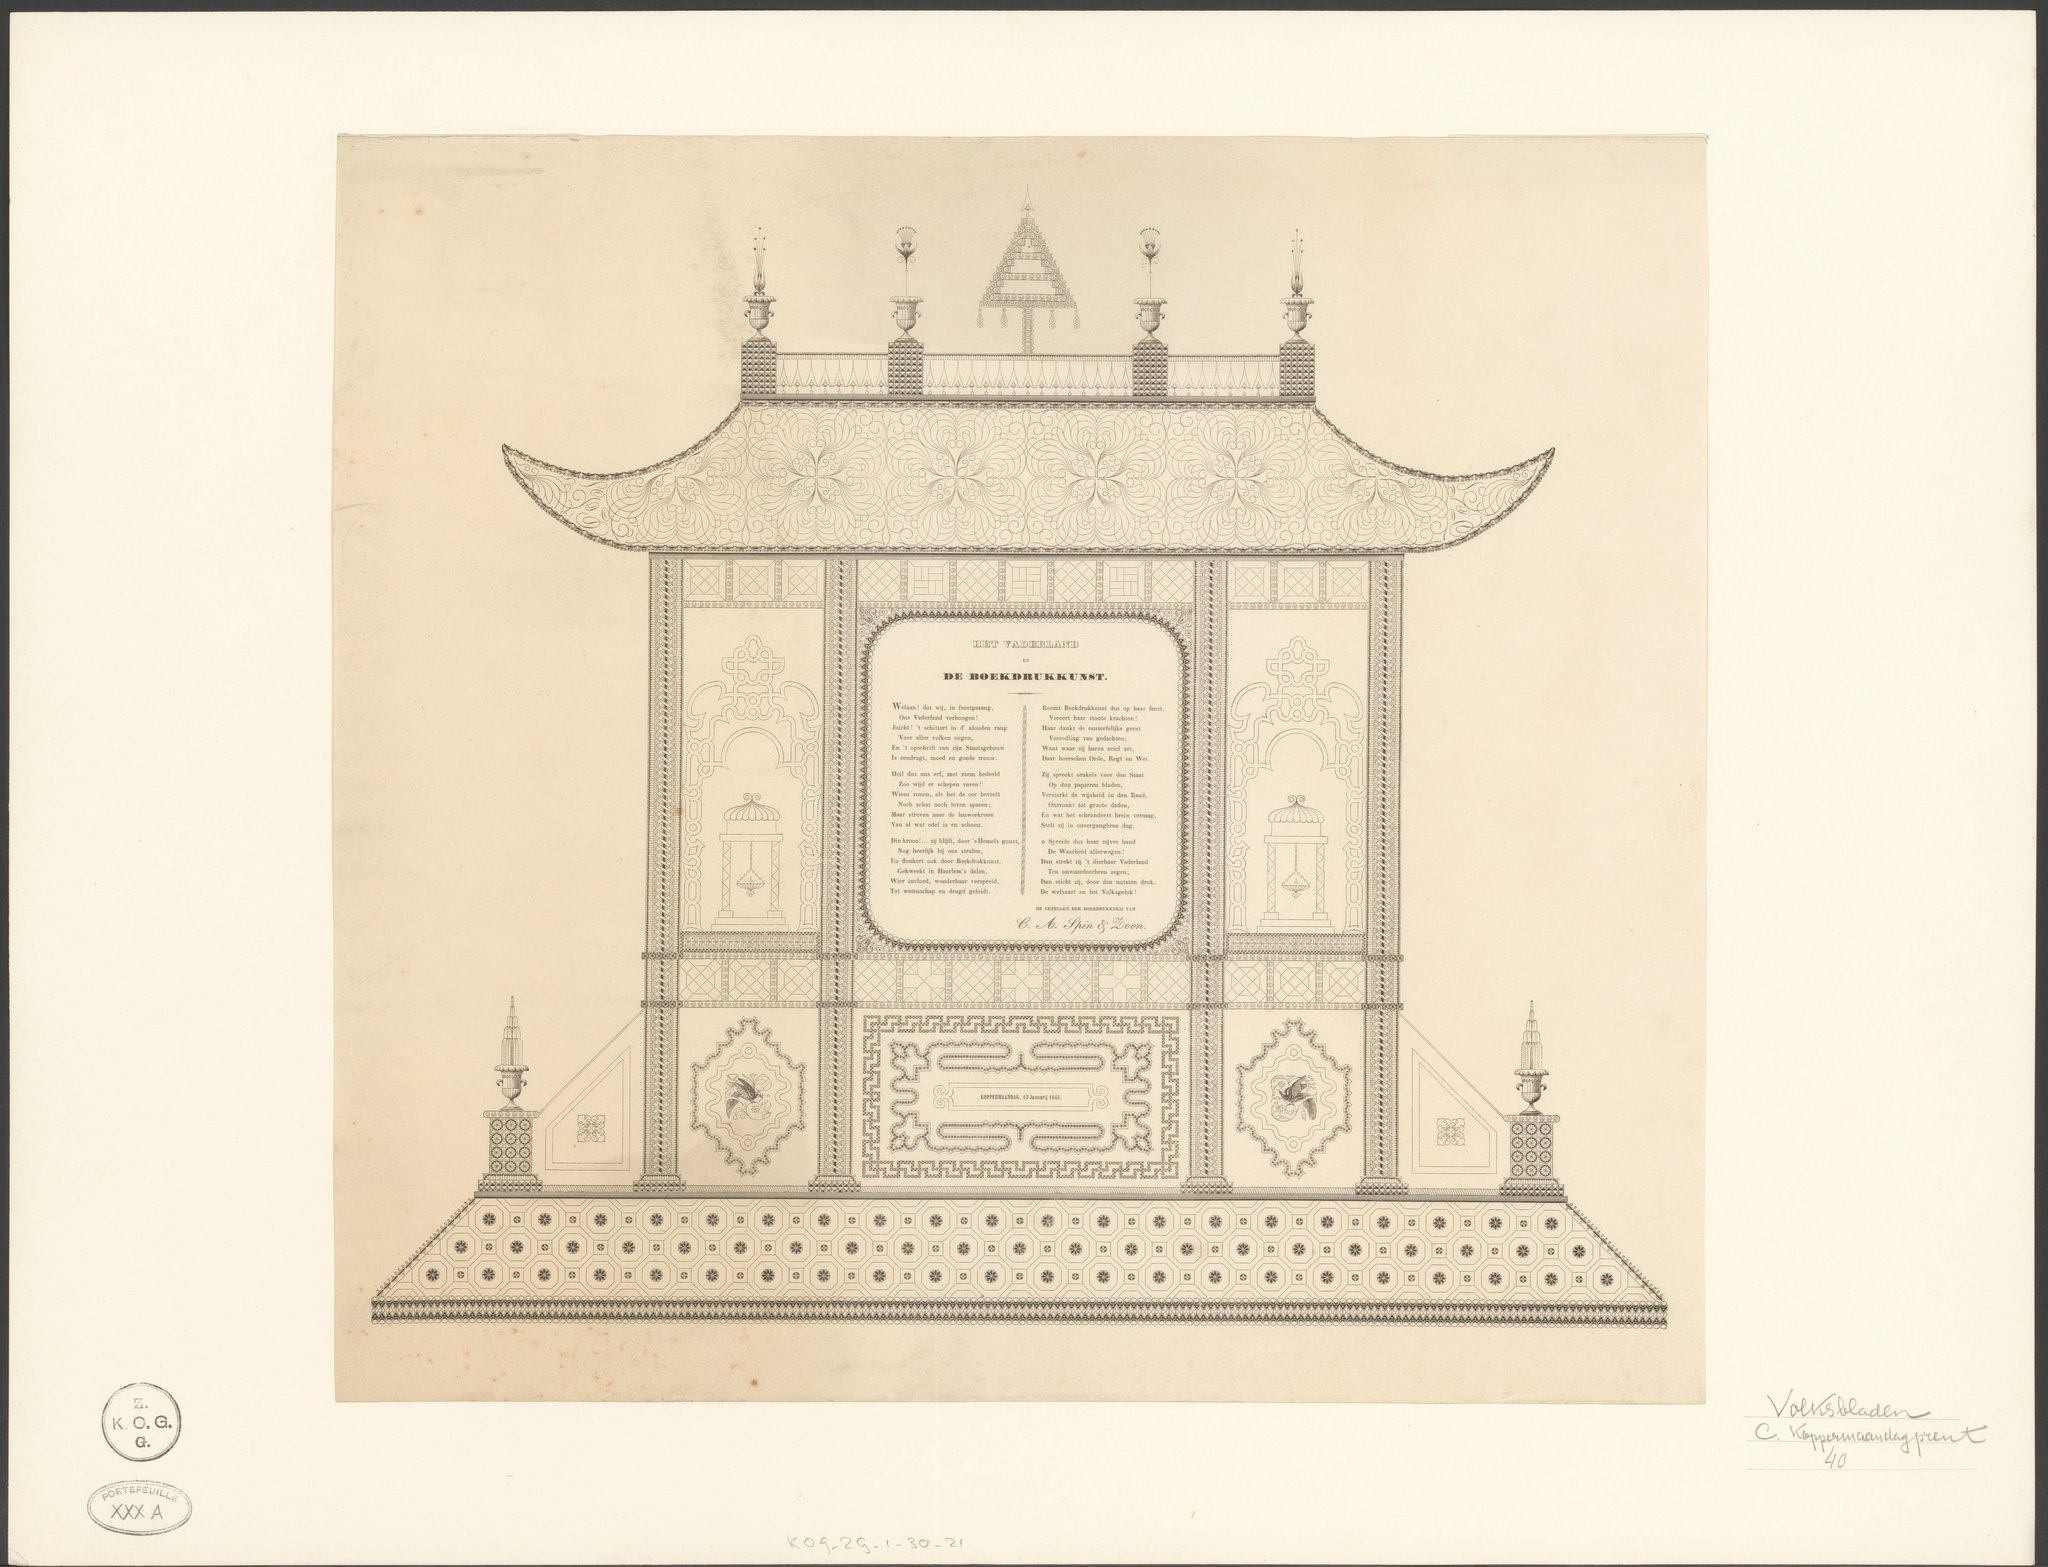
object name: photomechanical print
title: Het vaderland en de boekdrukkunst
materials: paper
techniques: letterpress printing, printing block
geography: amsterdam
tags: 'blue monday', civic architecture; edifices; dwellings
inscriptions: stamp, collector's mark: Lugt 1641, stamp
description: Koppermaandagprent door de gezellen van de boekdrukkerij van C.A. Spin & Zoon te Amsterdam, ter gelegenheid van Koppermaandag 13 januari 1845. In het midden van het gebouw een vers in twee kolommen van de gezellen. Onderwerpsrubrieken binnen de Atlas Zeden en Gewoonten: Zeden en Gewoonten in engeren zin. Volksleven. Volksbladen. Koppermaandagwenschen.